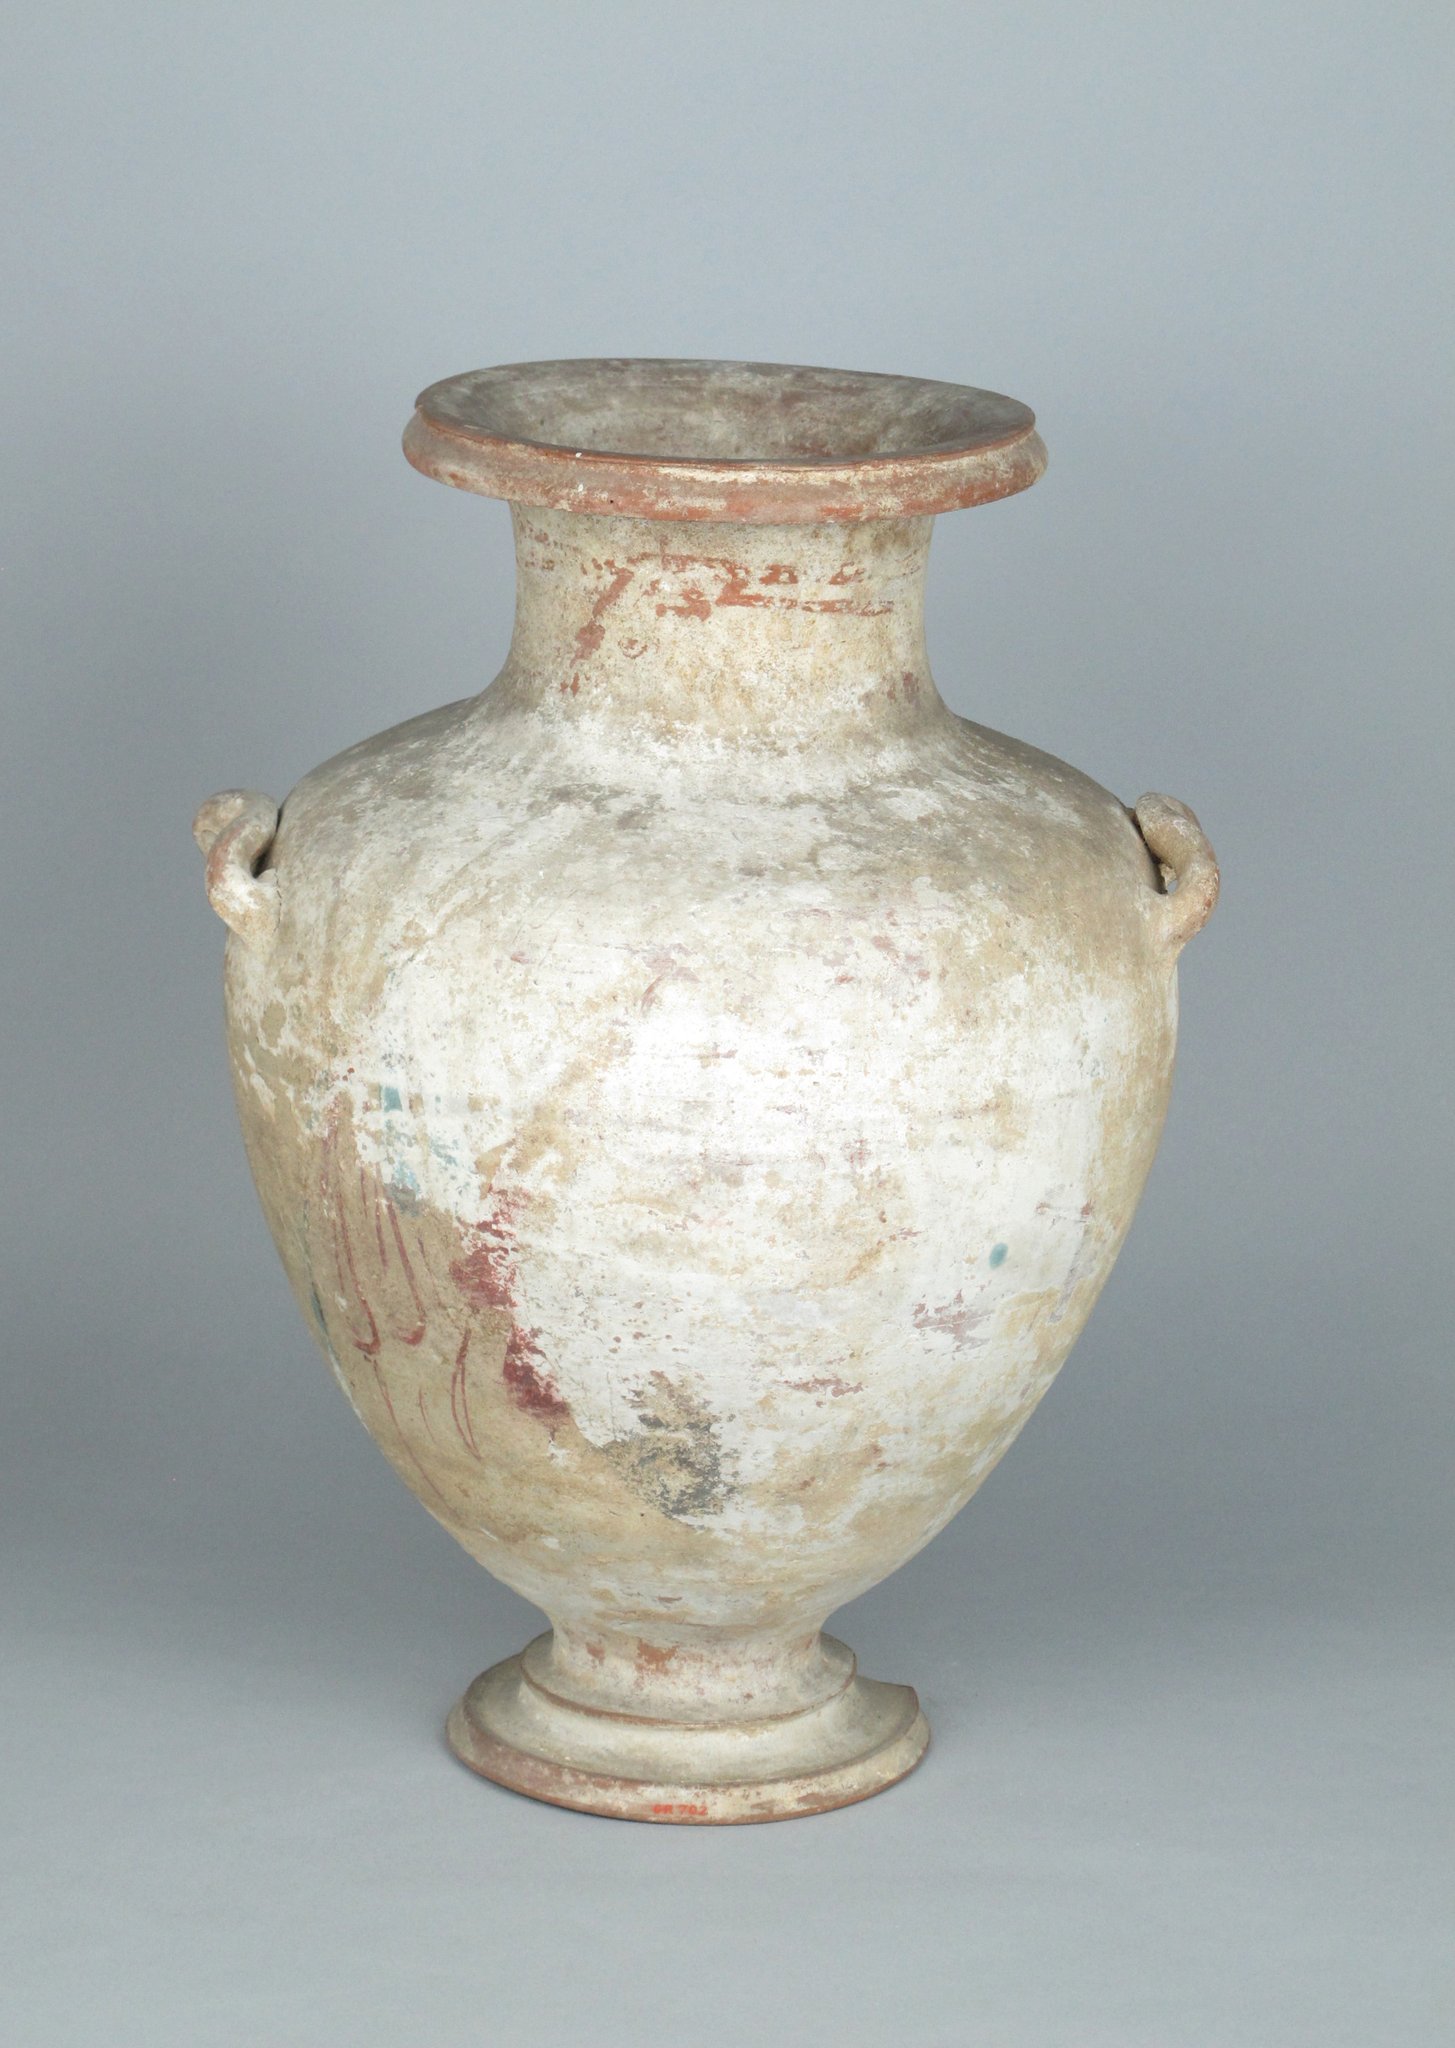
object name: hydria, hadra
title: Terracotta Hadra hydria (water jar)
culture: greek, egyptian, alexandria-hadra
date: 300-201 BCE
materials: terracotta